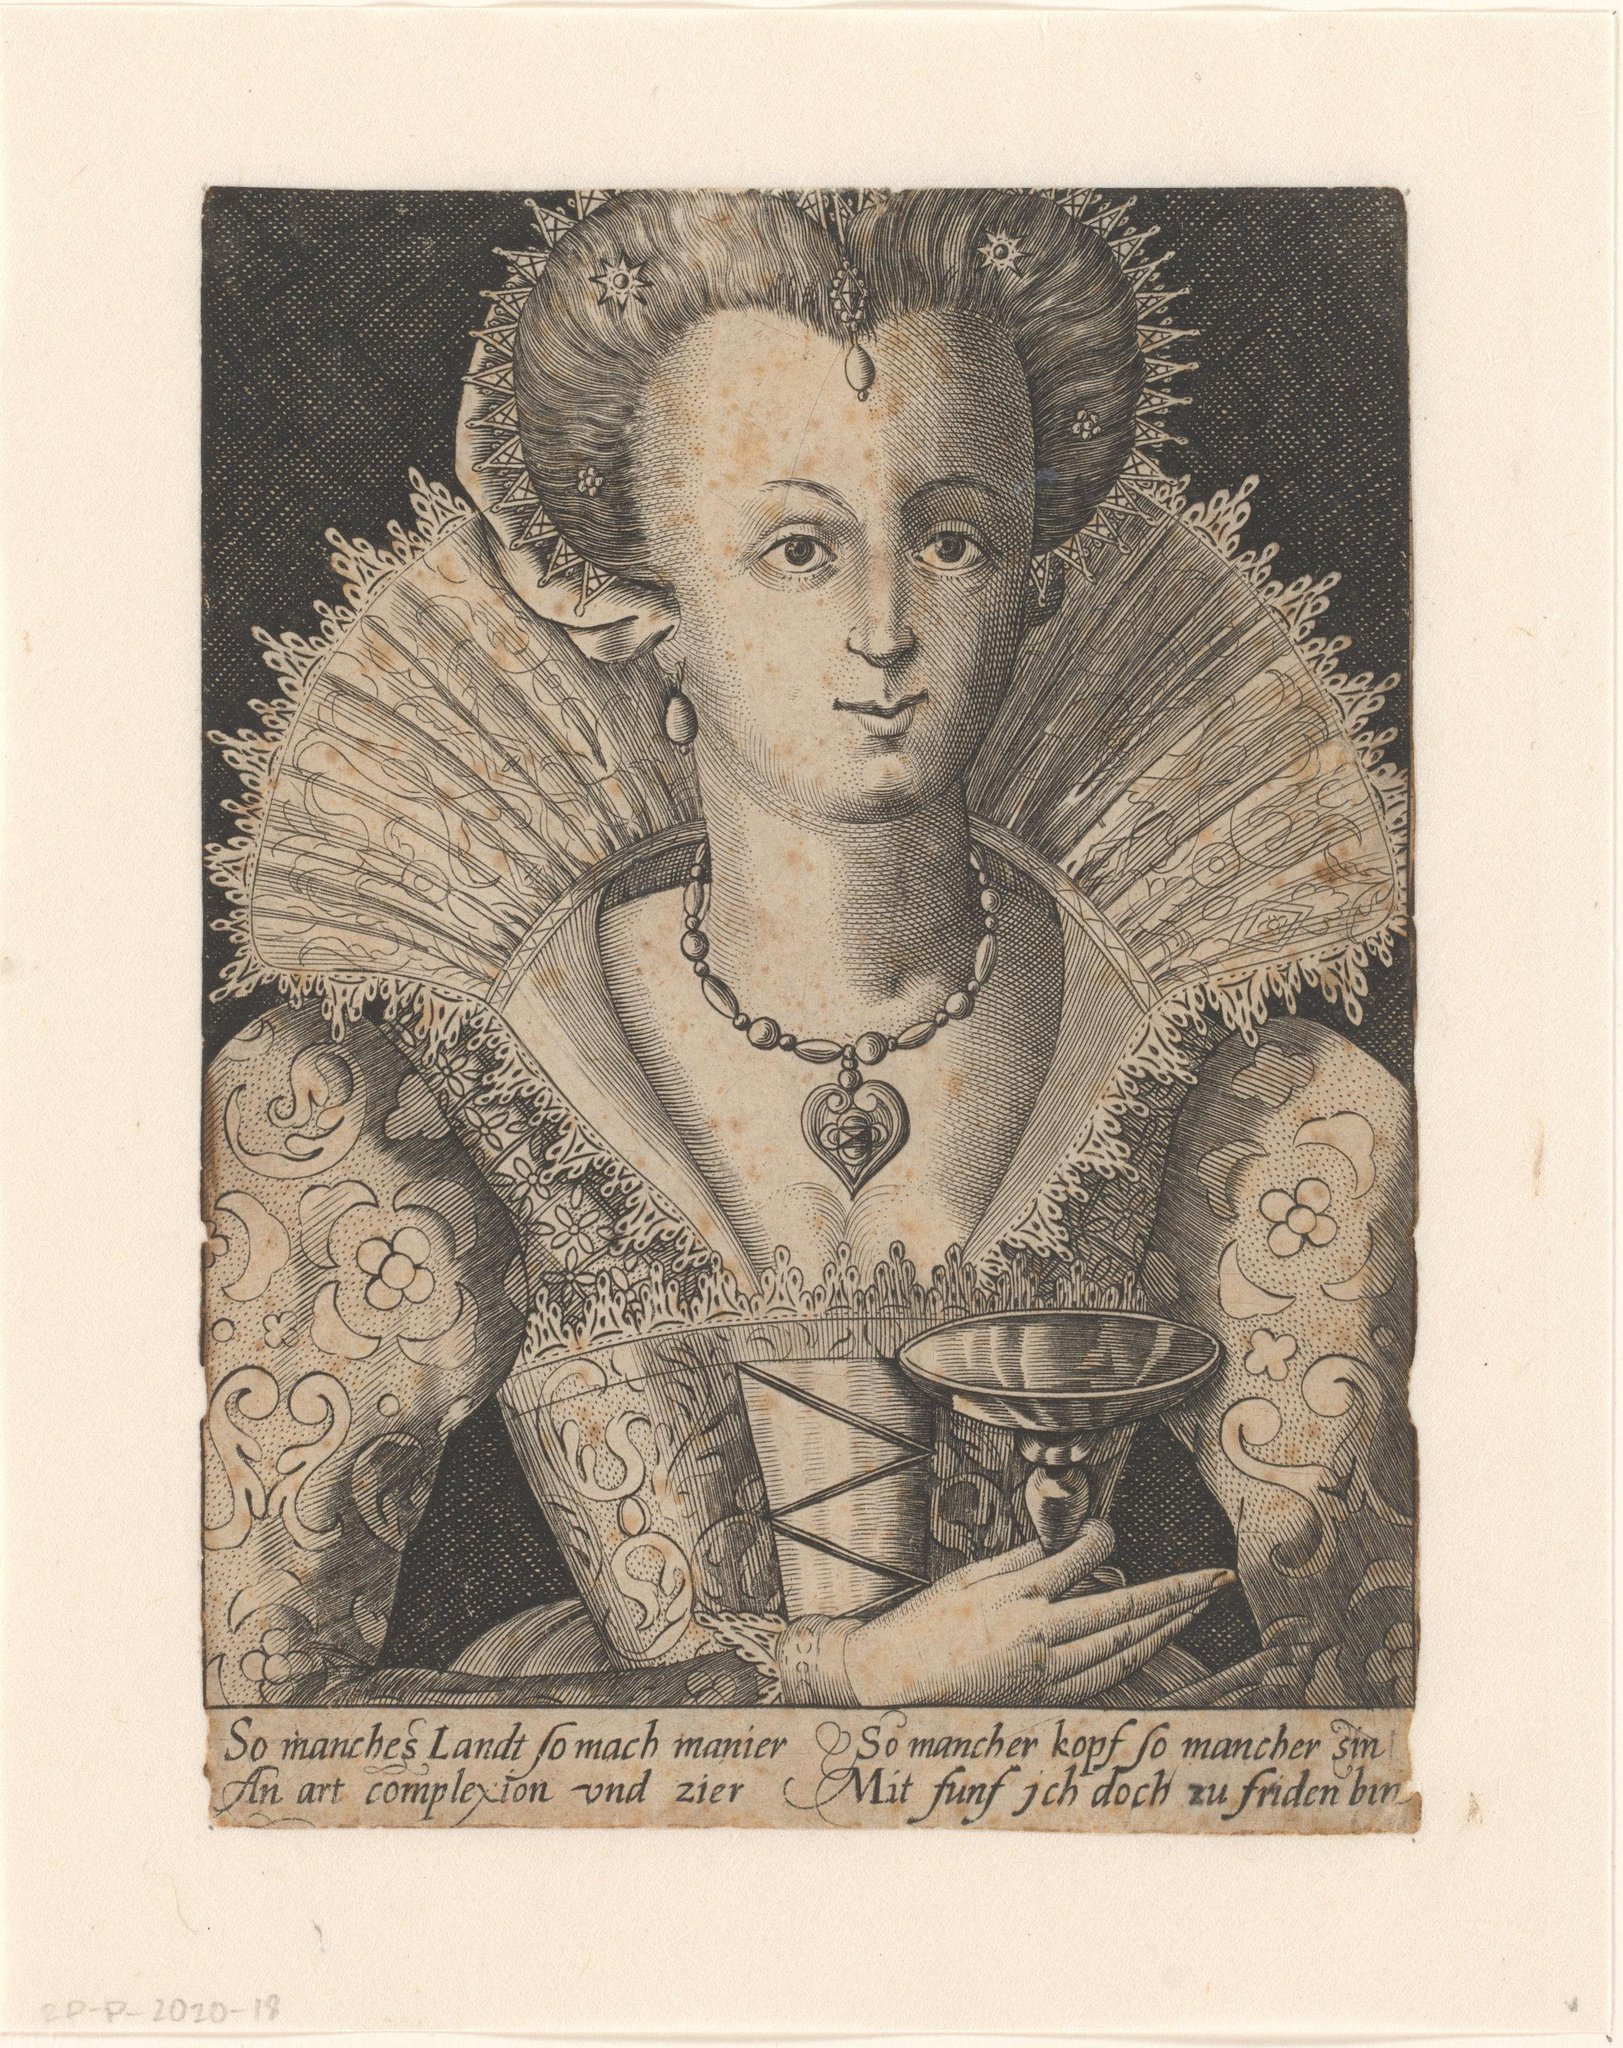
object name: print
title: Zintuig Smaak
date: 1590-1620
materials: paper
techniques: engraving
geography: low countries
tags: taste, tasting (one of the five senses), styles of hairdress - aa - ~ women, fashion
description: Zintuig Smaak. Jonge modieuze vrouw met een kelk in de hand. Prent uit een serie met vijf zintuigen, waarin de vijf zintuigen zijn gepersonifieerd door vrouwen in modieuze kostuums en met kapsels uit verschillende landen en voorzien van attributen. Met onderschrift in het Duits.